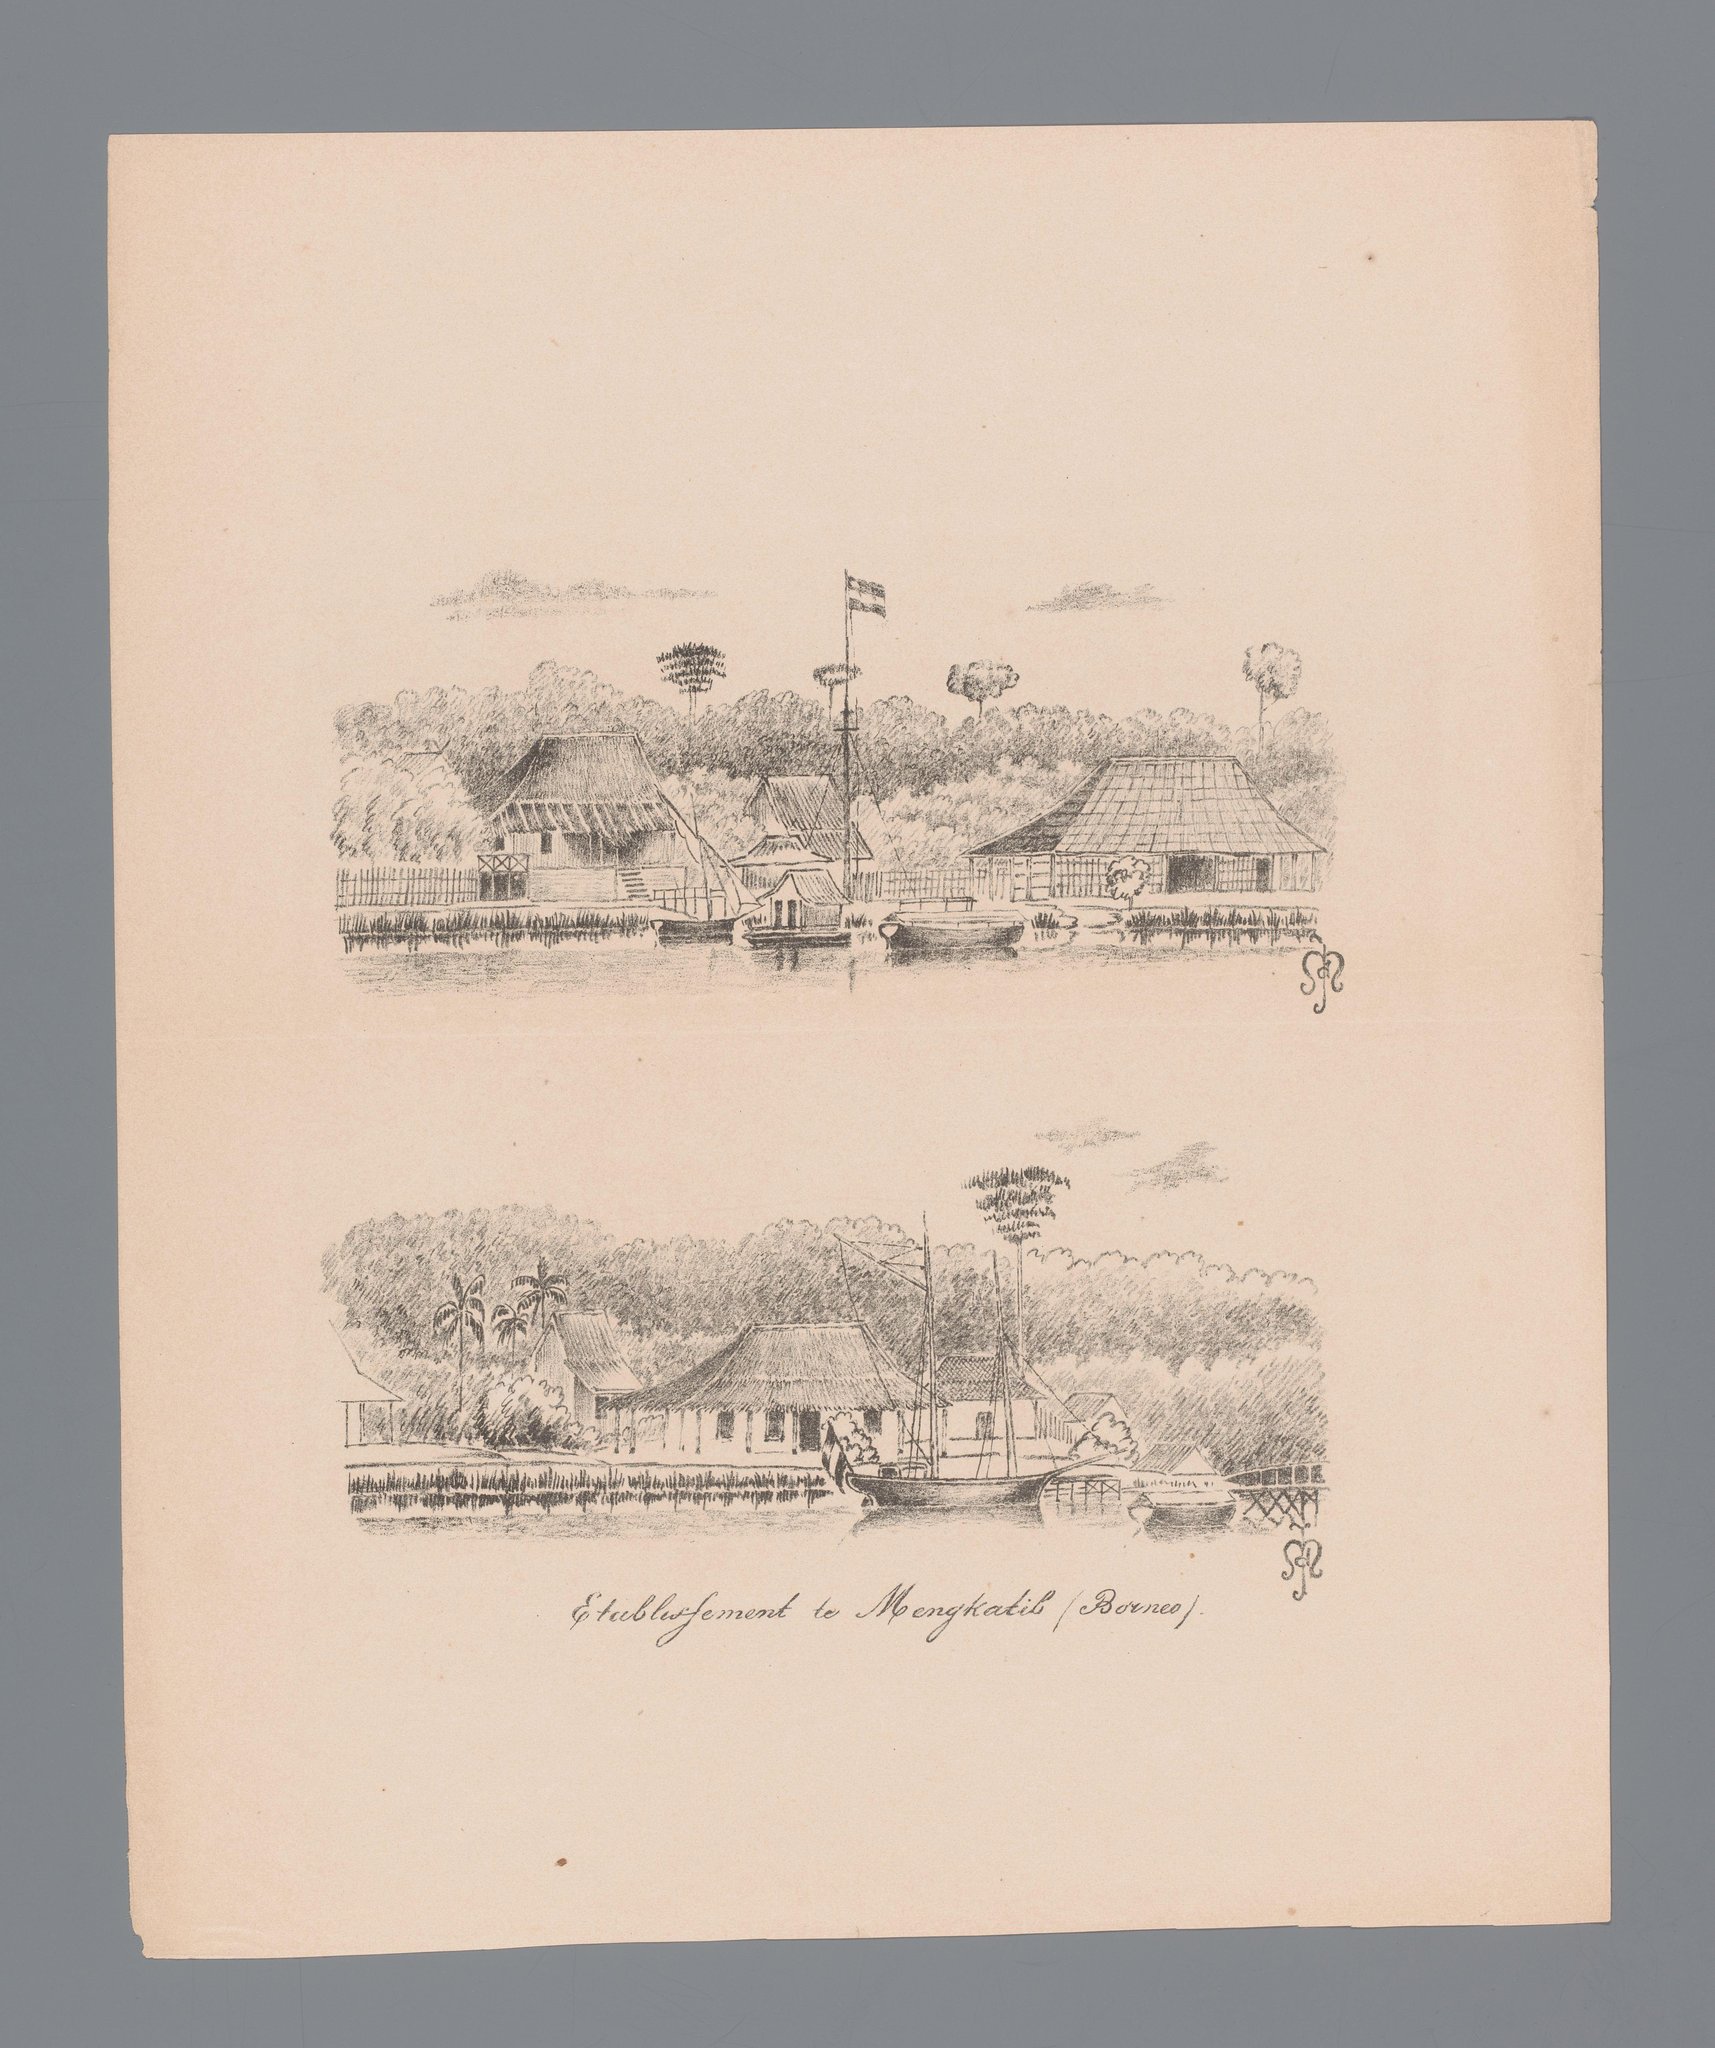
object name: print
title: Huizen te Mengkatib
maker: willem mathol de jong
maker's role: print maker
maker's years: 1828-1886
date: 1838-1886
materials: paper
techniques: lithograph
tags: river, borneo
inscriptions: collector's mark: Lugt 2228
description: De huizen staan aan de kant van de rivier de Barito. Maakt deel uit van een omslag met twaalf prenten.